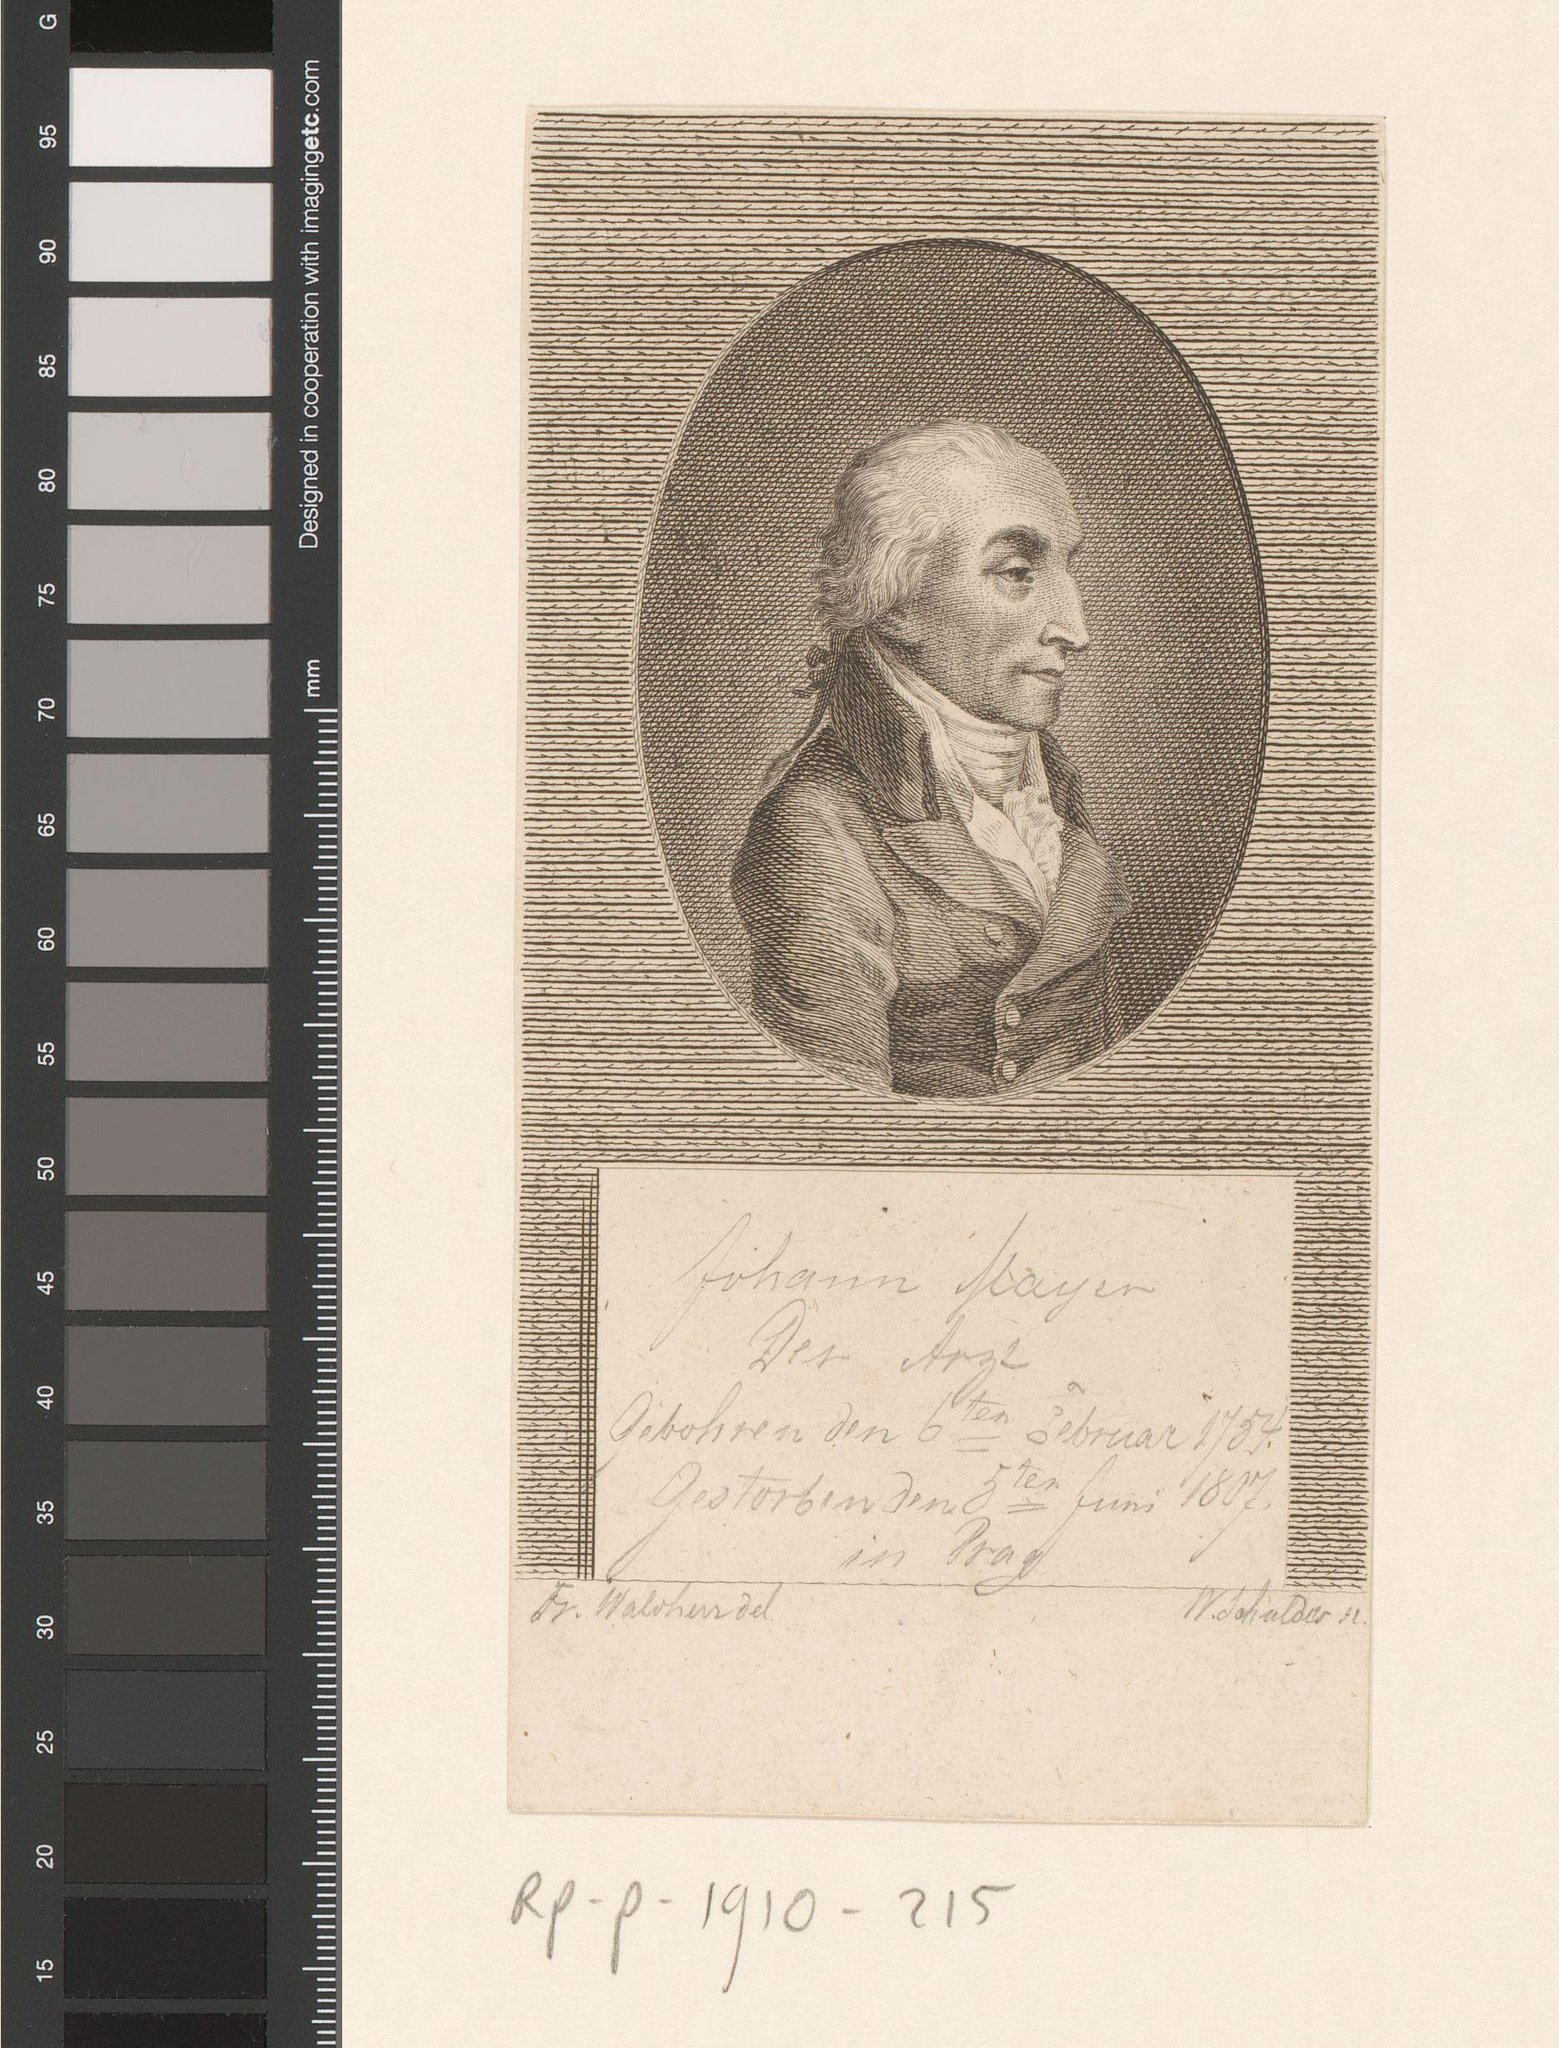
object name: print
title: Portret van Johann Mayer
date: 1787-1828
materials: paper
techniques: engraving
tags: historical persons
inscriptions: collector's mark: Lugt 2228